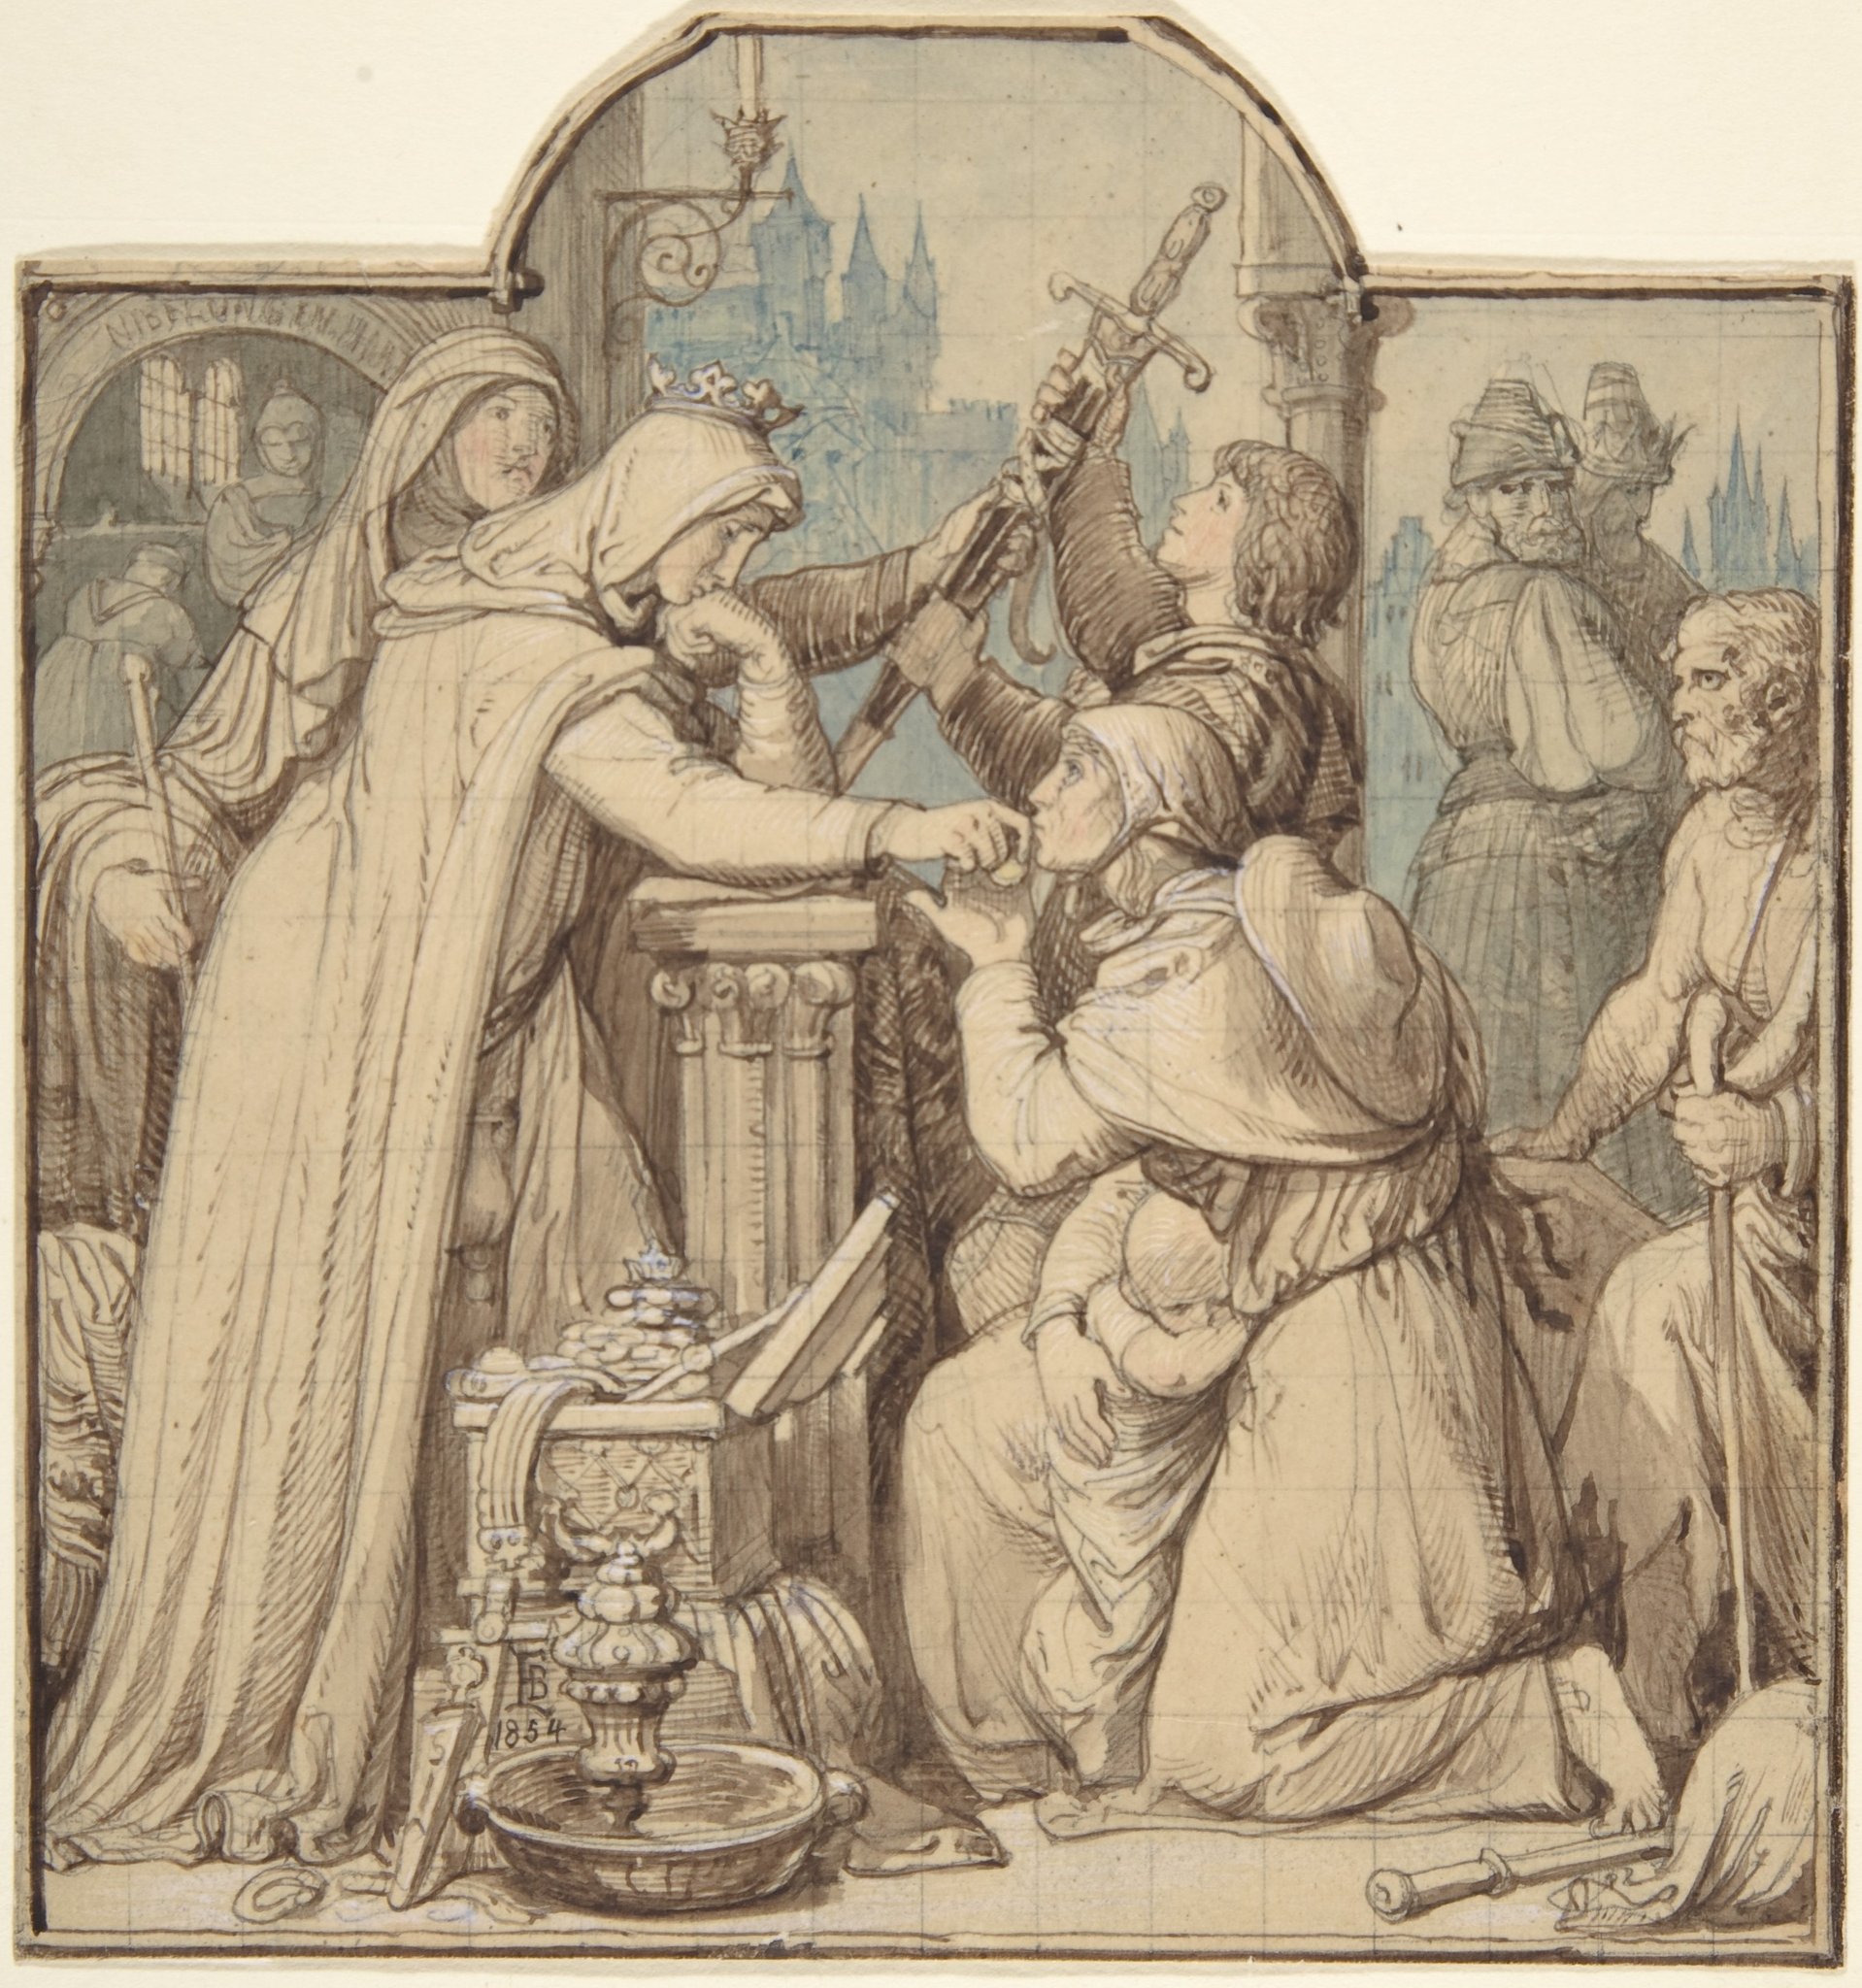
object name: drawing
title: Kriemhild, in Mourning over Siegfried, Handing Out Treasures from the Nibelungen Hoard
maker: eduard julius friedrich bendemann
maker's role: artist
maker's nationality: german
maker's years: 1811-1889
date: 1854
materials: graphite, ink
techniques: brush, pen, wash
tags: swords,sadness,children,men,women